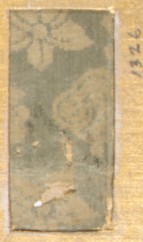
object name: piece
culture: japanese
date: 1701-1900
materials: silk